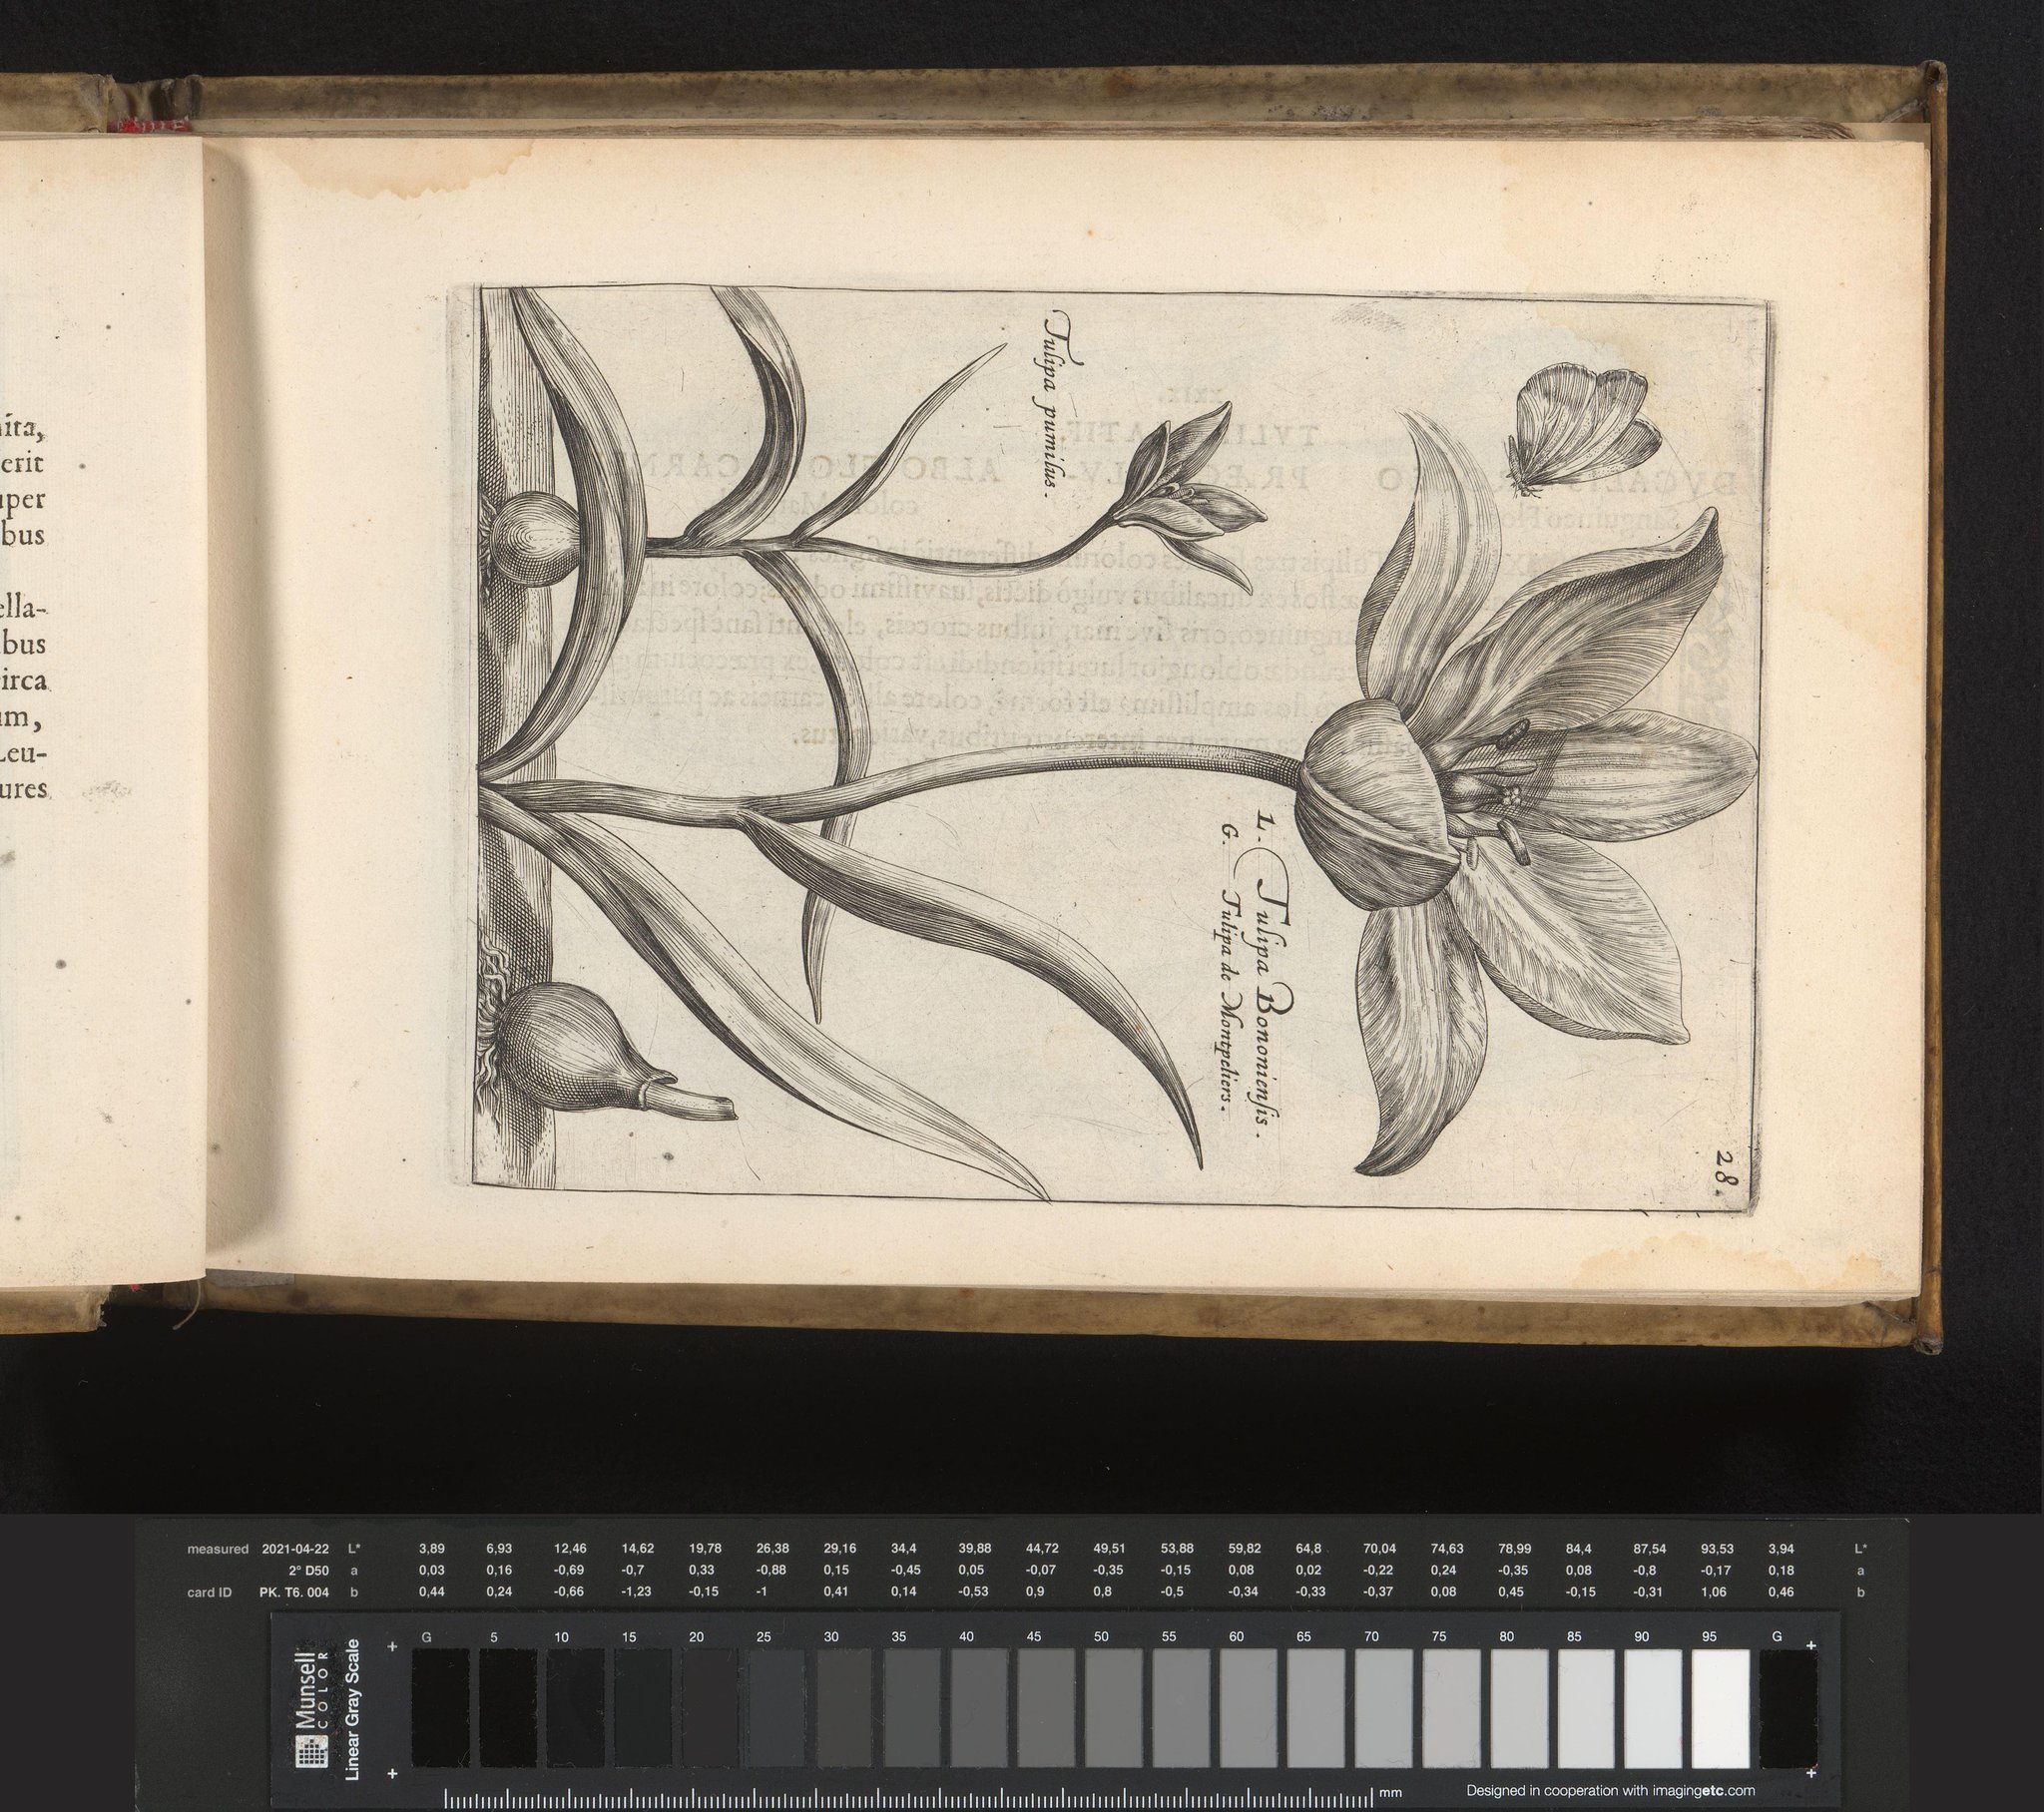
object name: page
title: Tulipa Bononiensis / Tulipa de Montpeliers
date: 1617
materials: paper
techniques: engraving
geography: utrecht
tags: flowers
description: Prent uit: Passe, Crispijn van de (II). Hortus floridus in quo rariorum & minus vulgarium florum icones ad vivam veramque formam. Arnhem: Johannes Janssonius, 1617.